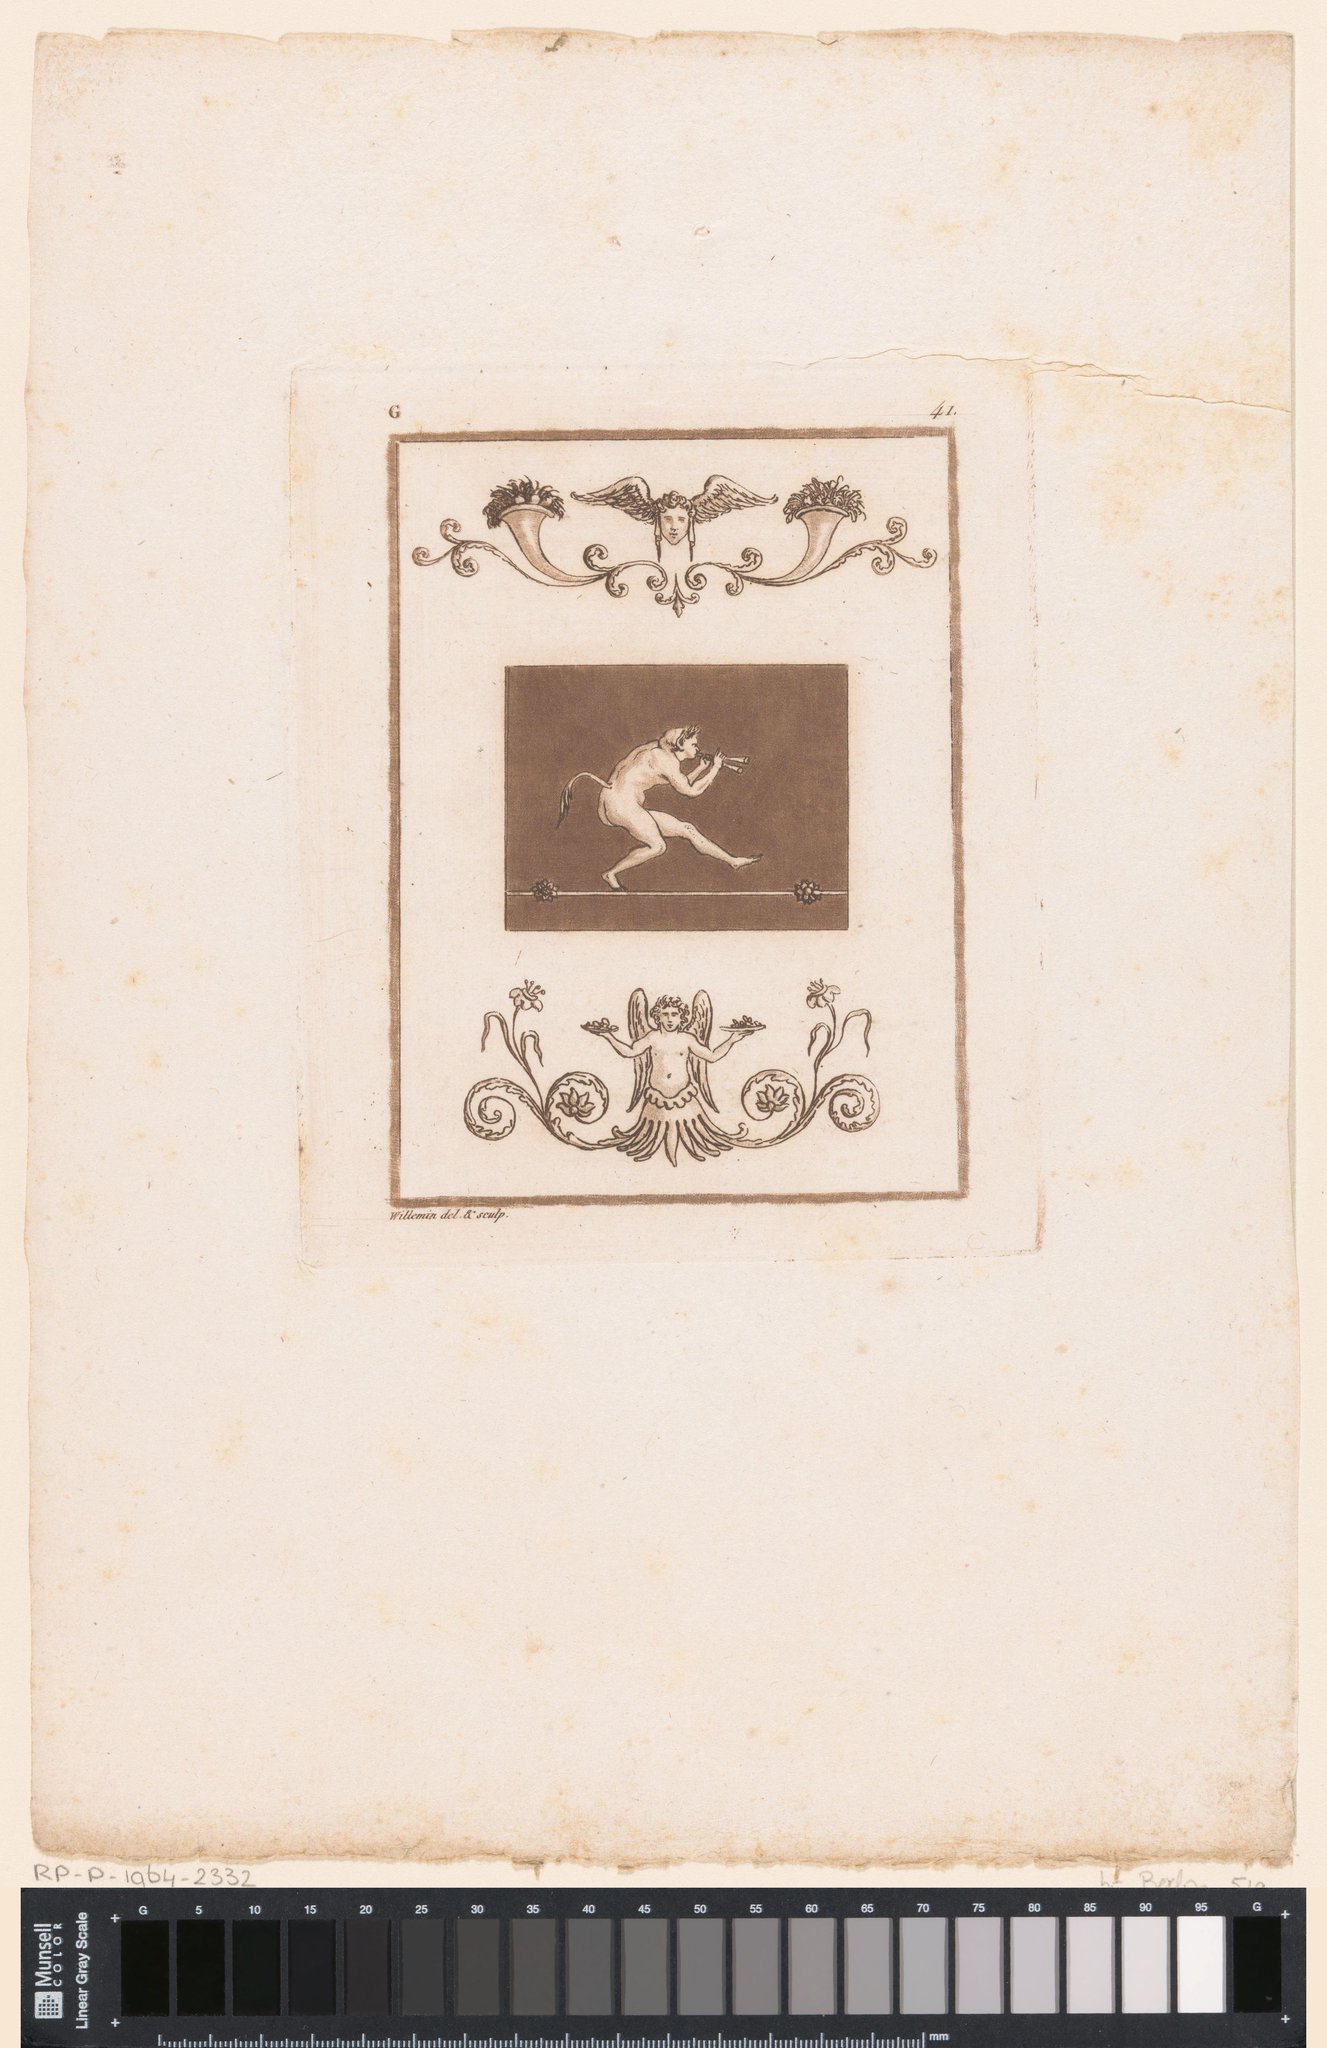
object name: print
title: Fluitspelende sater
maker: nicolas xavier willemin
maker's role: print maker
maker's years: 1763-1839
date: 1775-1797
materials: paper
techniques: aquatint, etching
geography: paris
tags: making music; musician with instrument, satyr(s) (in general)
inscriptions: collector's mark: Lugt 2760, collector's mark: Lugt 2228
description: Een sater spelend op een dubbele fluit. Boven en onder de voorstelling vlechtwerk met hoornen des overvloeds en een engel.